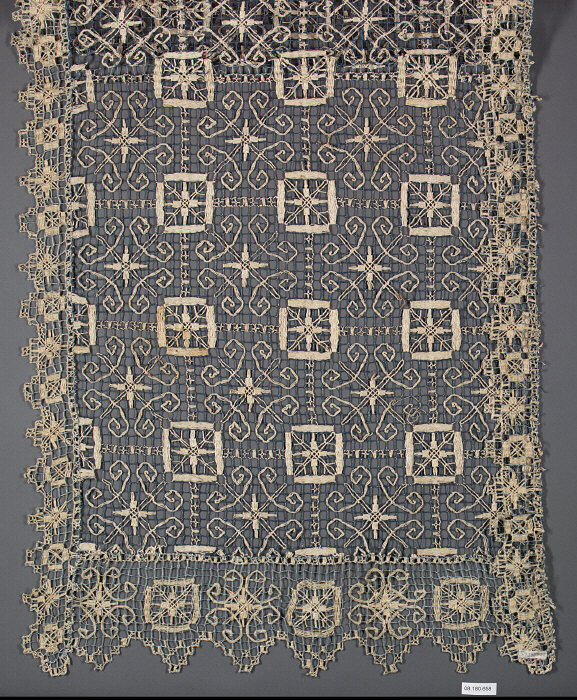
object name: cover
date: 1801-1900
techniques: embroidery